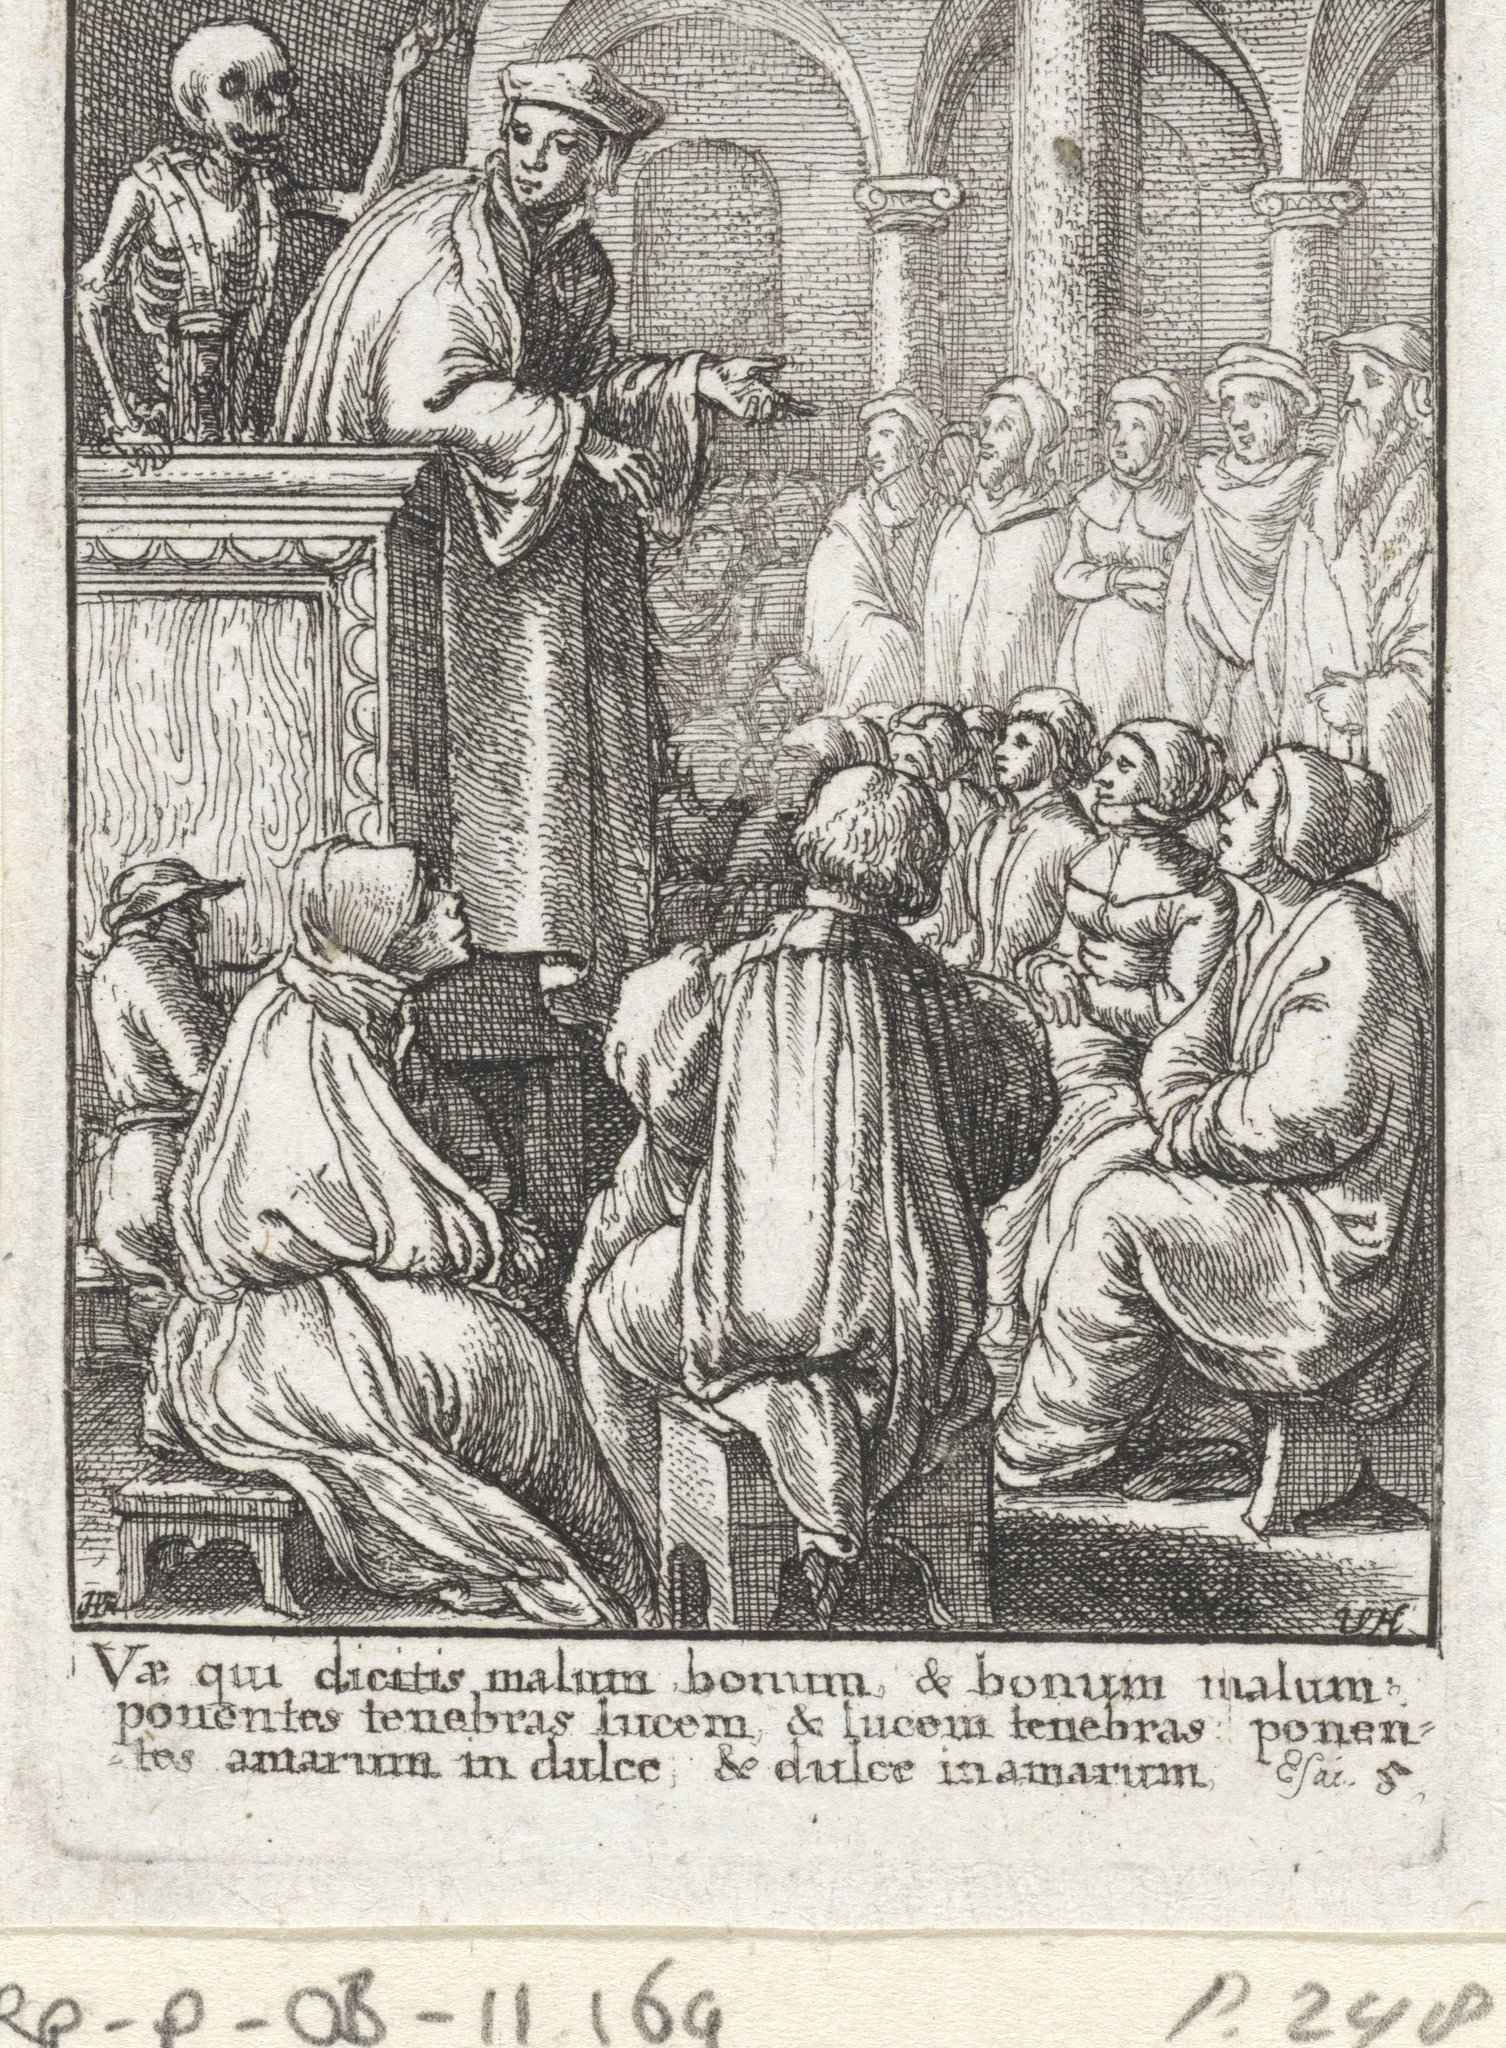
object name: print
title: De predikant en de Dood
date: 1680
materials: paper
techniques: etching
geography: antwerp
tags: dance of death; death together with one or more human beings, functionaries and dignitaries ~ episcopal protestant churches, hourglass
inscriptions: collector's mark: Lugt 240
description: Een predikant preekt vanaf een kansel in de kerk. Achter hem staat de Dood met een zandloper.